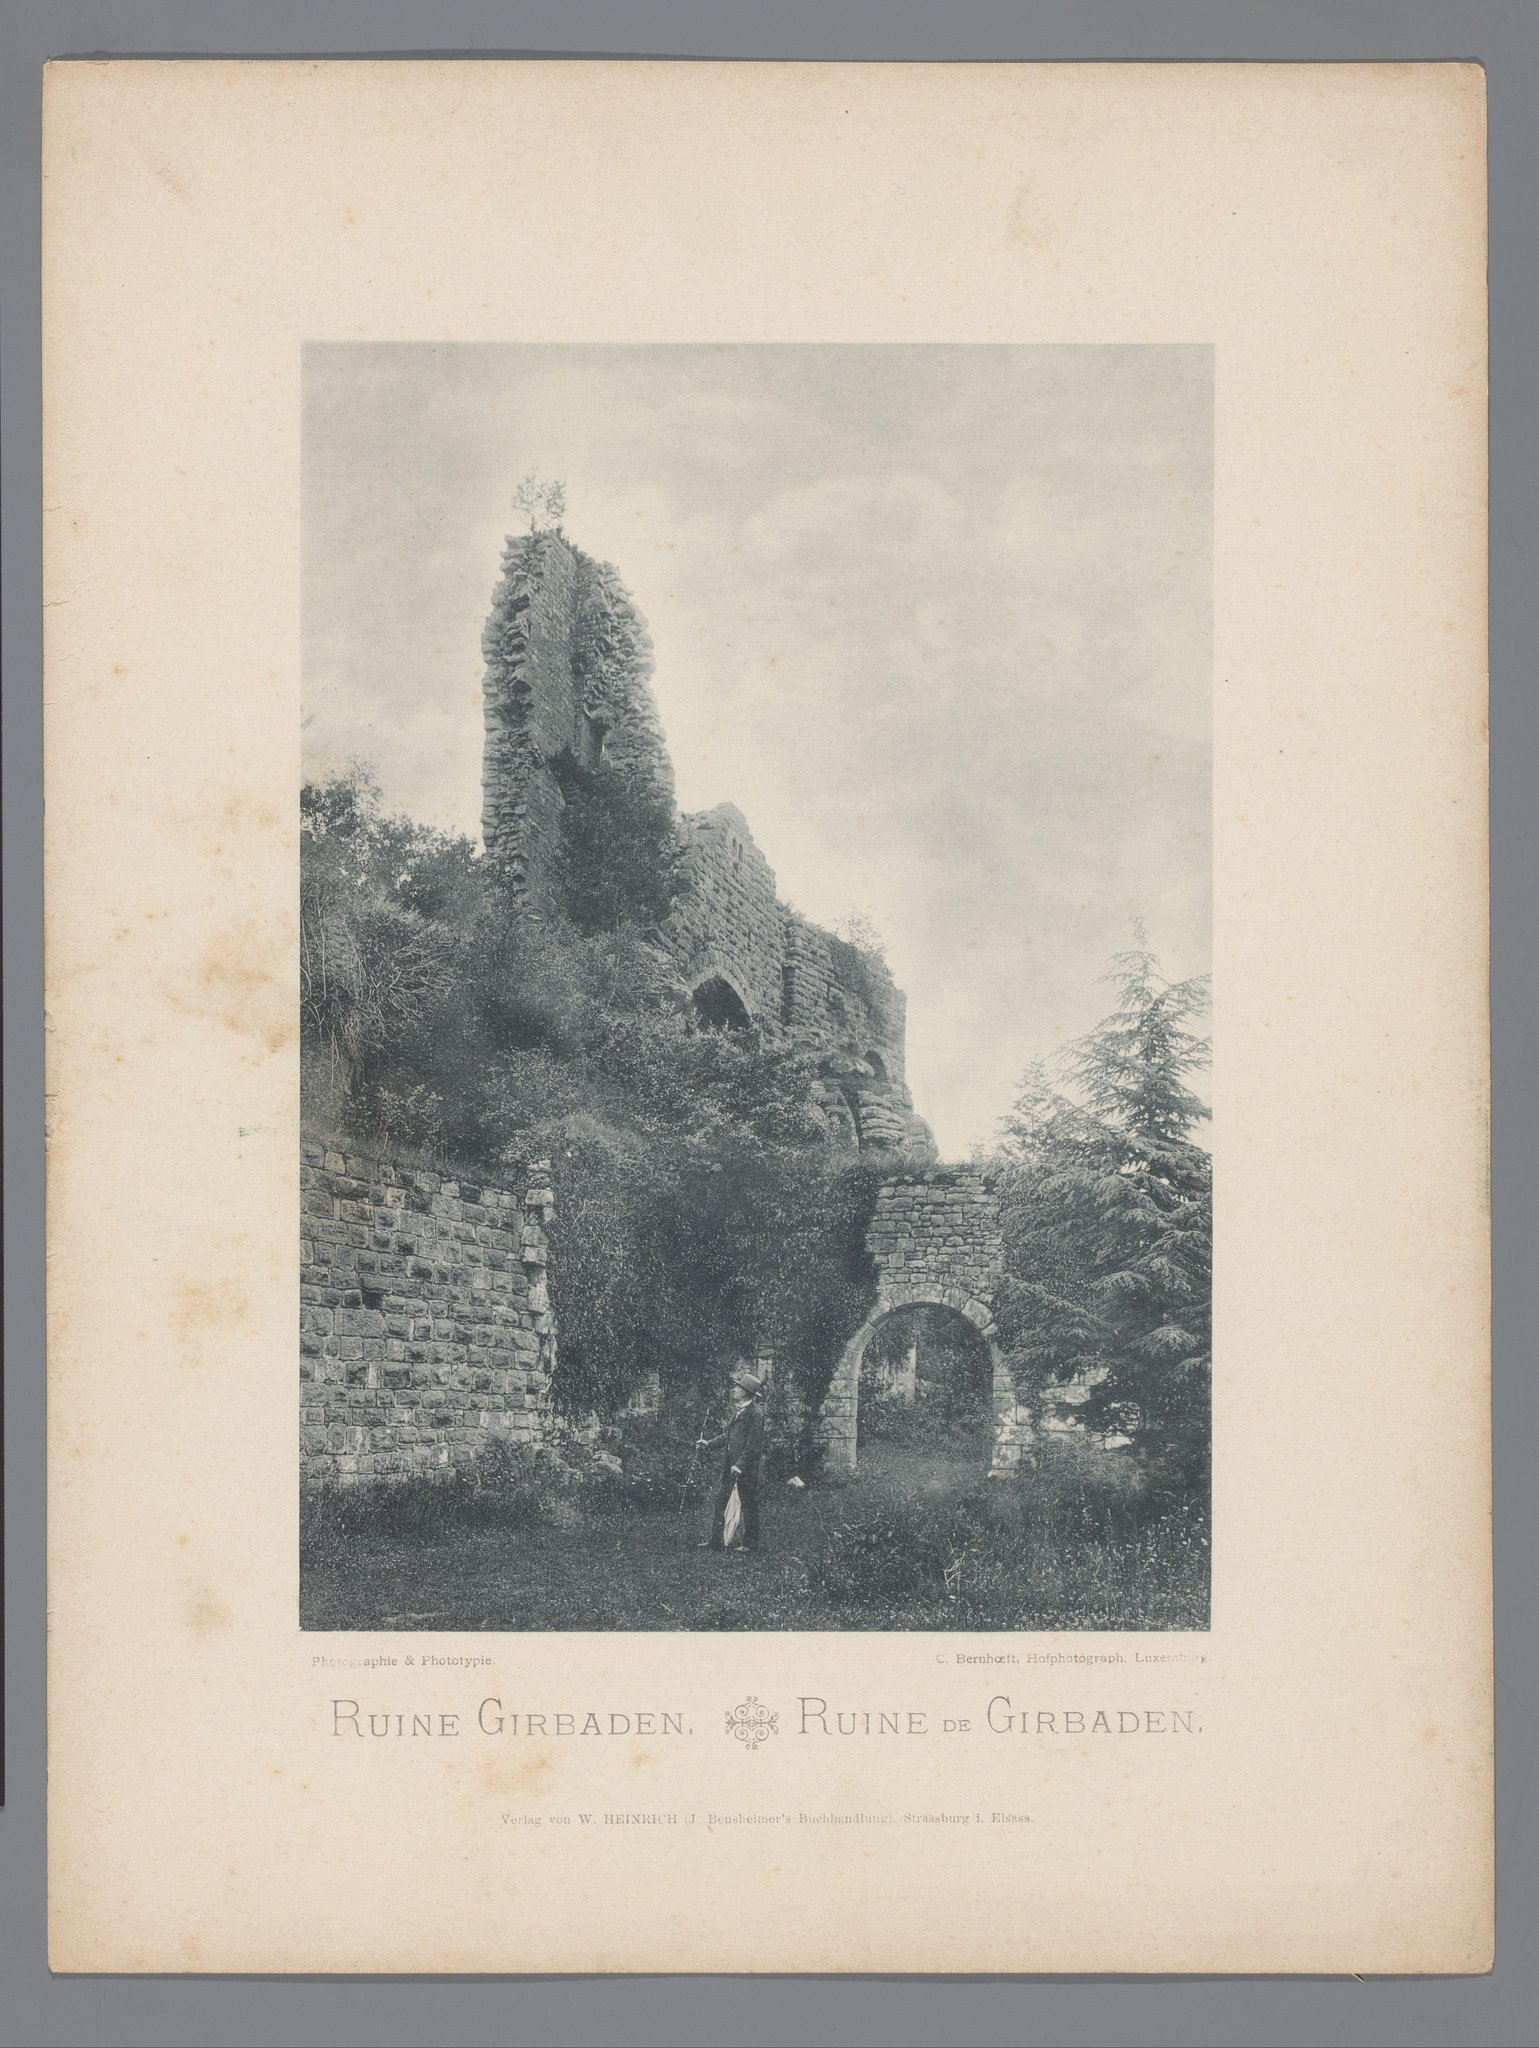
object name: photomechanical print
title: Ruine Girbaden, Ruine de Girbaden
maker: charles bernhoeft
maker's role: publisher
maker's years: 1859-1933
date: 1889-1894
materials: paper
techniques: photograph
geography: straatsburg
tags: castle, landscape with ruins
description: Deze prent maakt deel uit van een omslag met 100 prenten.